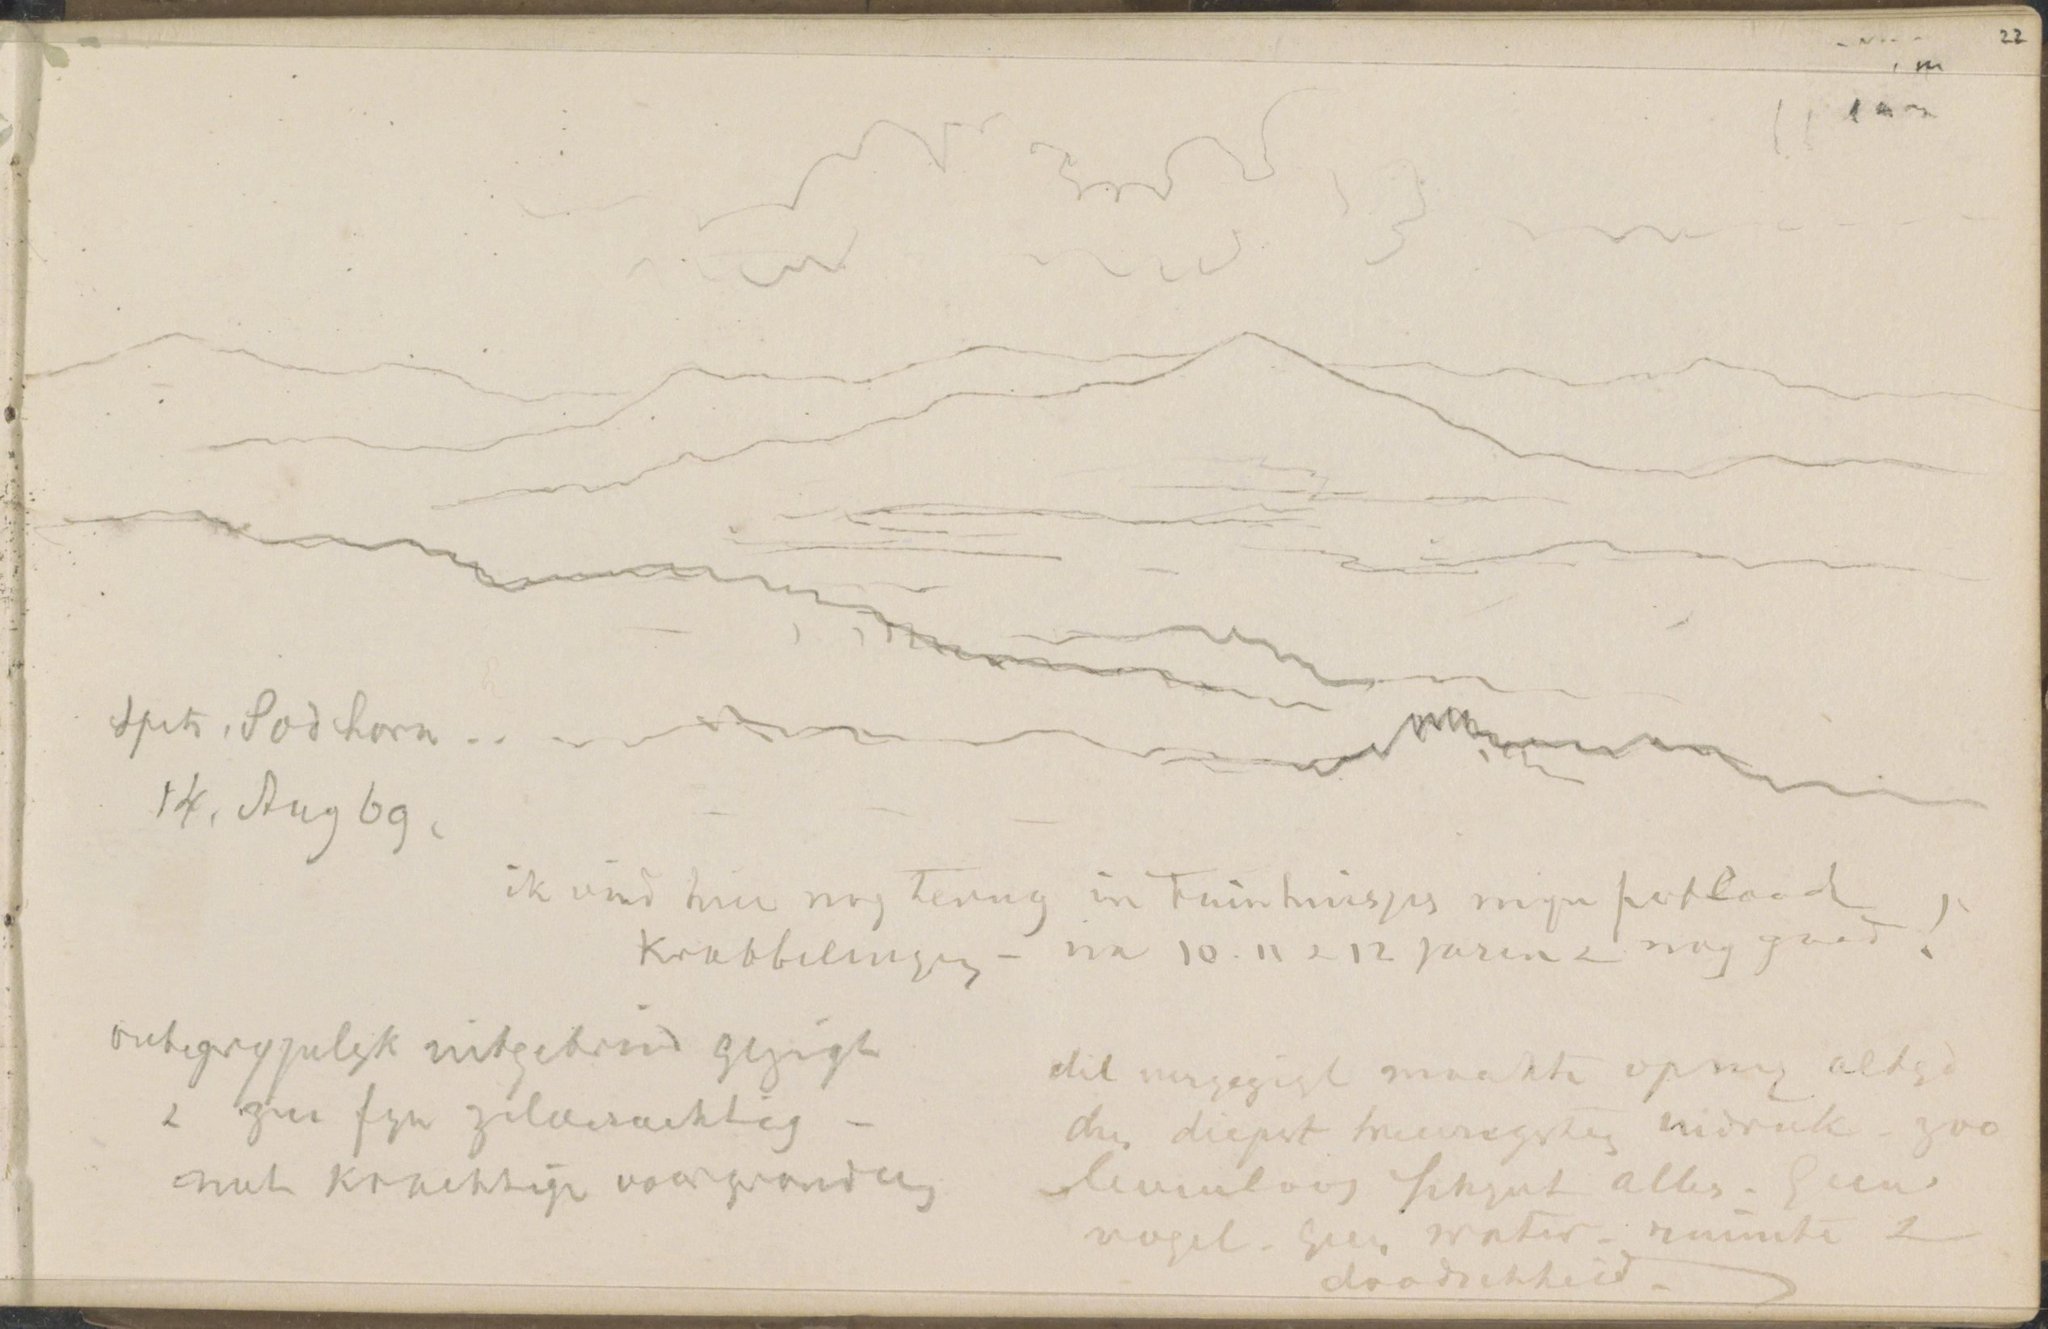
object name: sketchbook leaf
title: Spits van de berg Podhorn in Marienbad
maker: johannes tavenraat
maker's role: draughtsman, painter, print maker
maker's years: 1809-1881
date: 1808-1869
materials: paper, pencil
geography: marienbad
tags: mountains, marienbad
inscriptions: date and inscription: ‘spits. Podhorn/ 14.Aug 69/ ik vind hier nog terug in tuinhuisjes mijn potlood/ krabbelingen - na 10.11. & jaren & nog goed!’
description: Blad 22 recto uit een schetsboek met 48 bladen.